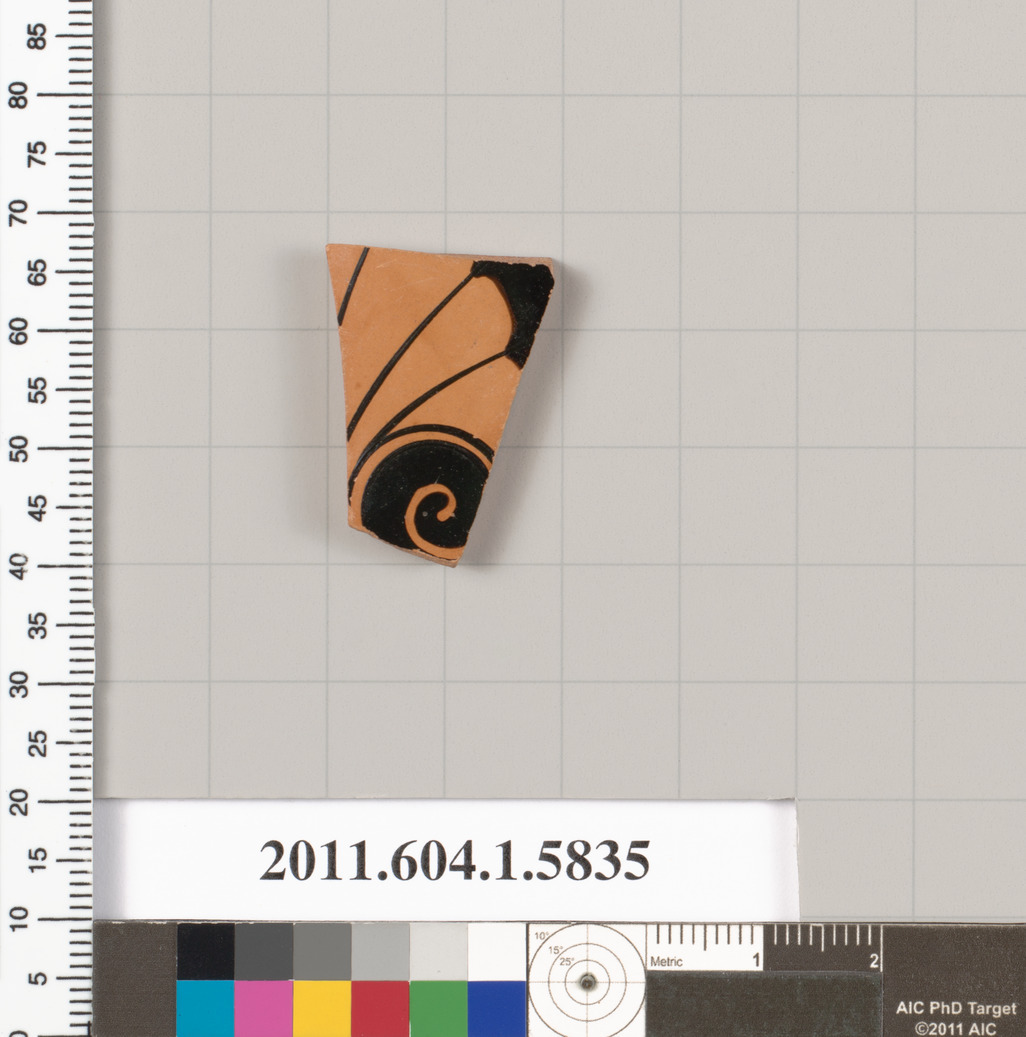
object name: kylix fragment, eye cup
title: Terracotta fragment of a kylix: eye-cup (drinking cup)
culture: greek, attic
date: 520-510 BCE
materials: terracotta